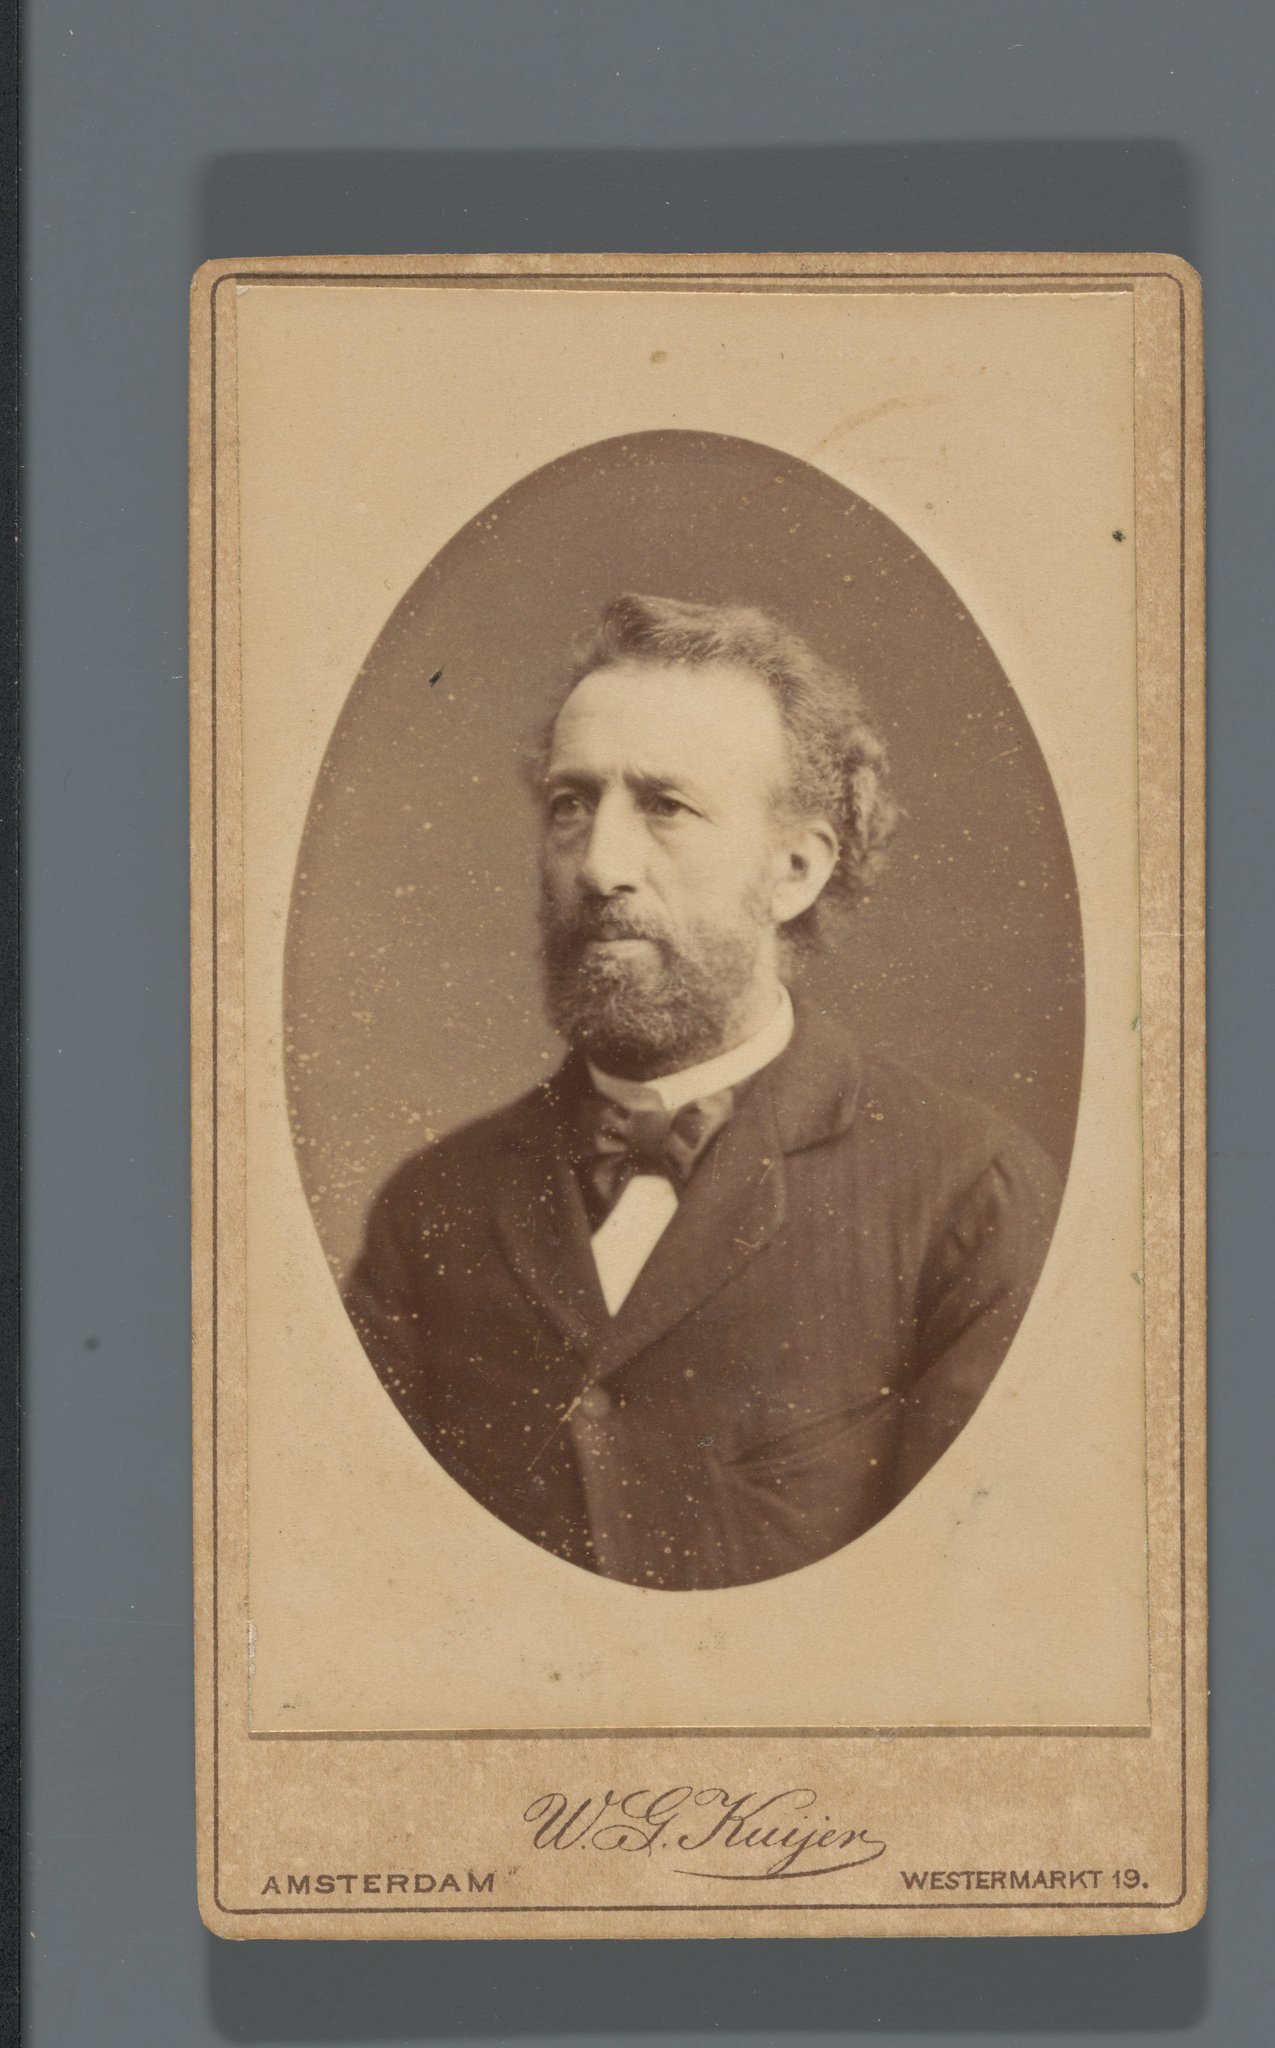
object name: photograph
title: Portret van een man uit de familie Marmelstein, vermoedelijk de vader van A. F. Marmelstein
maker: willem gerhardus kuijer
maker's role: fotograaf, hoffotograaf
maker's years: 1834-1899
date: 1850-1900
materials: cardboard, photographic support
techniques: albumen print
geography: amsterdam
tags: adult man, historical persons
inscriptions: retailer's mark: ‘W.G. Kuijer/ Westermarkt 19/ Amsterdam/ 5’